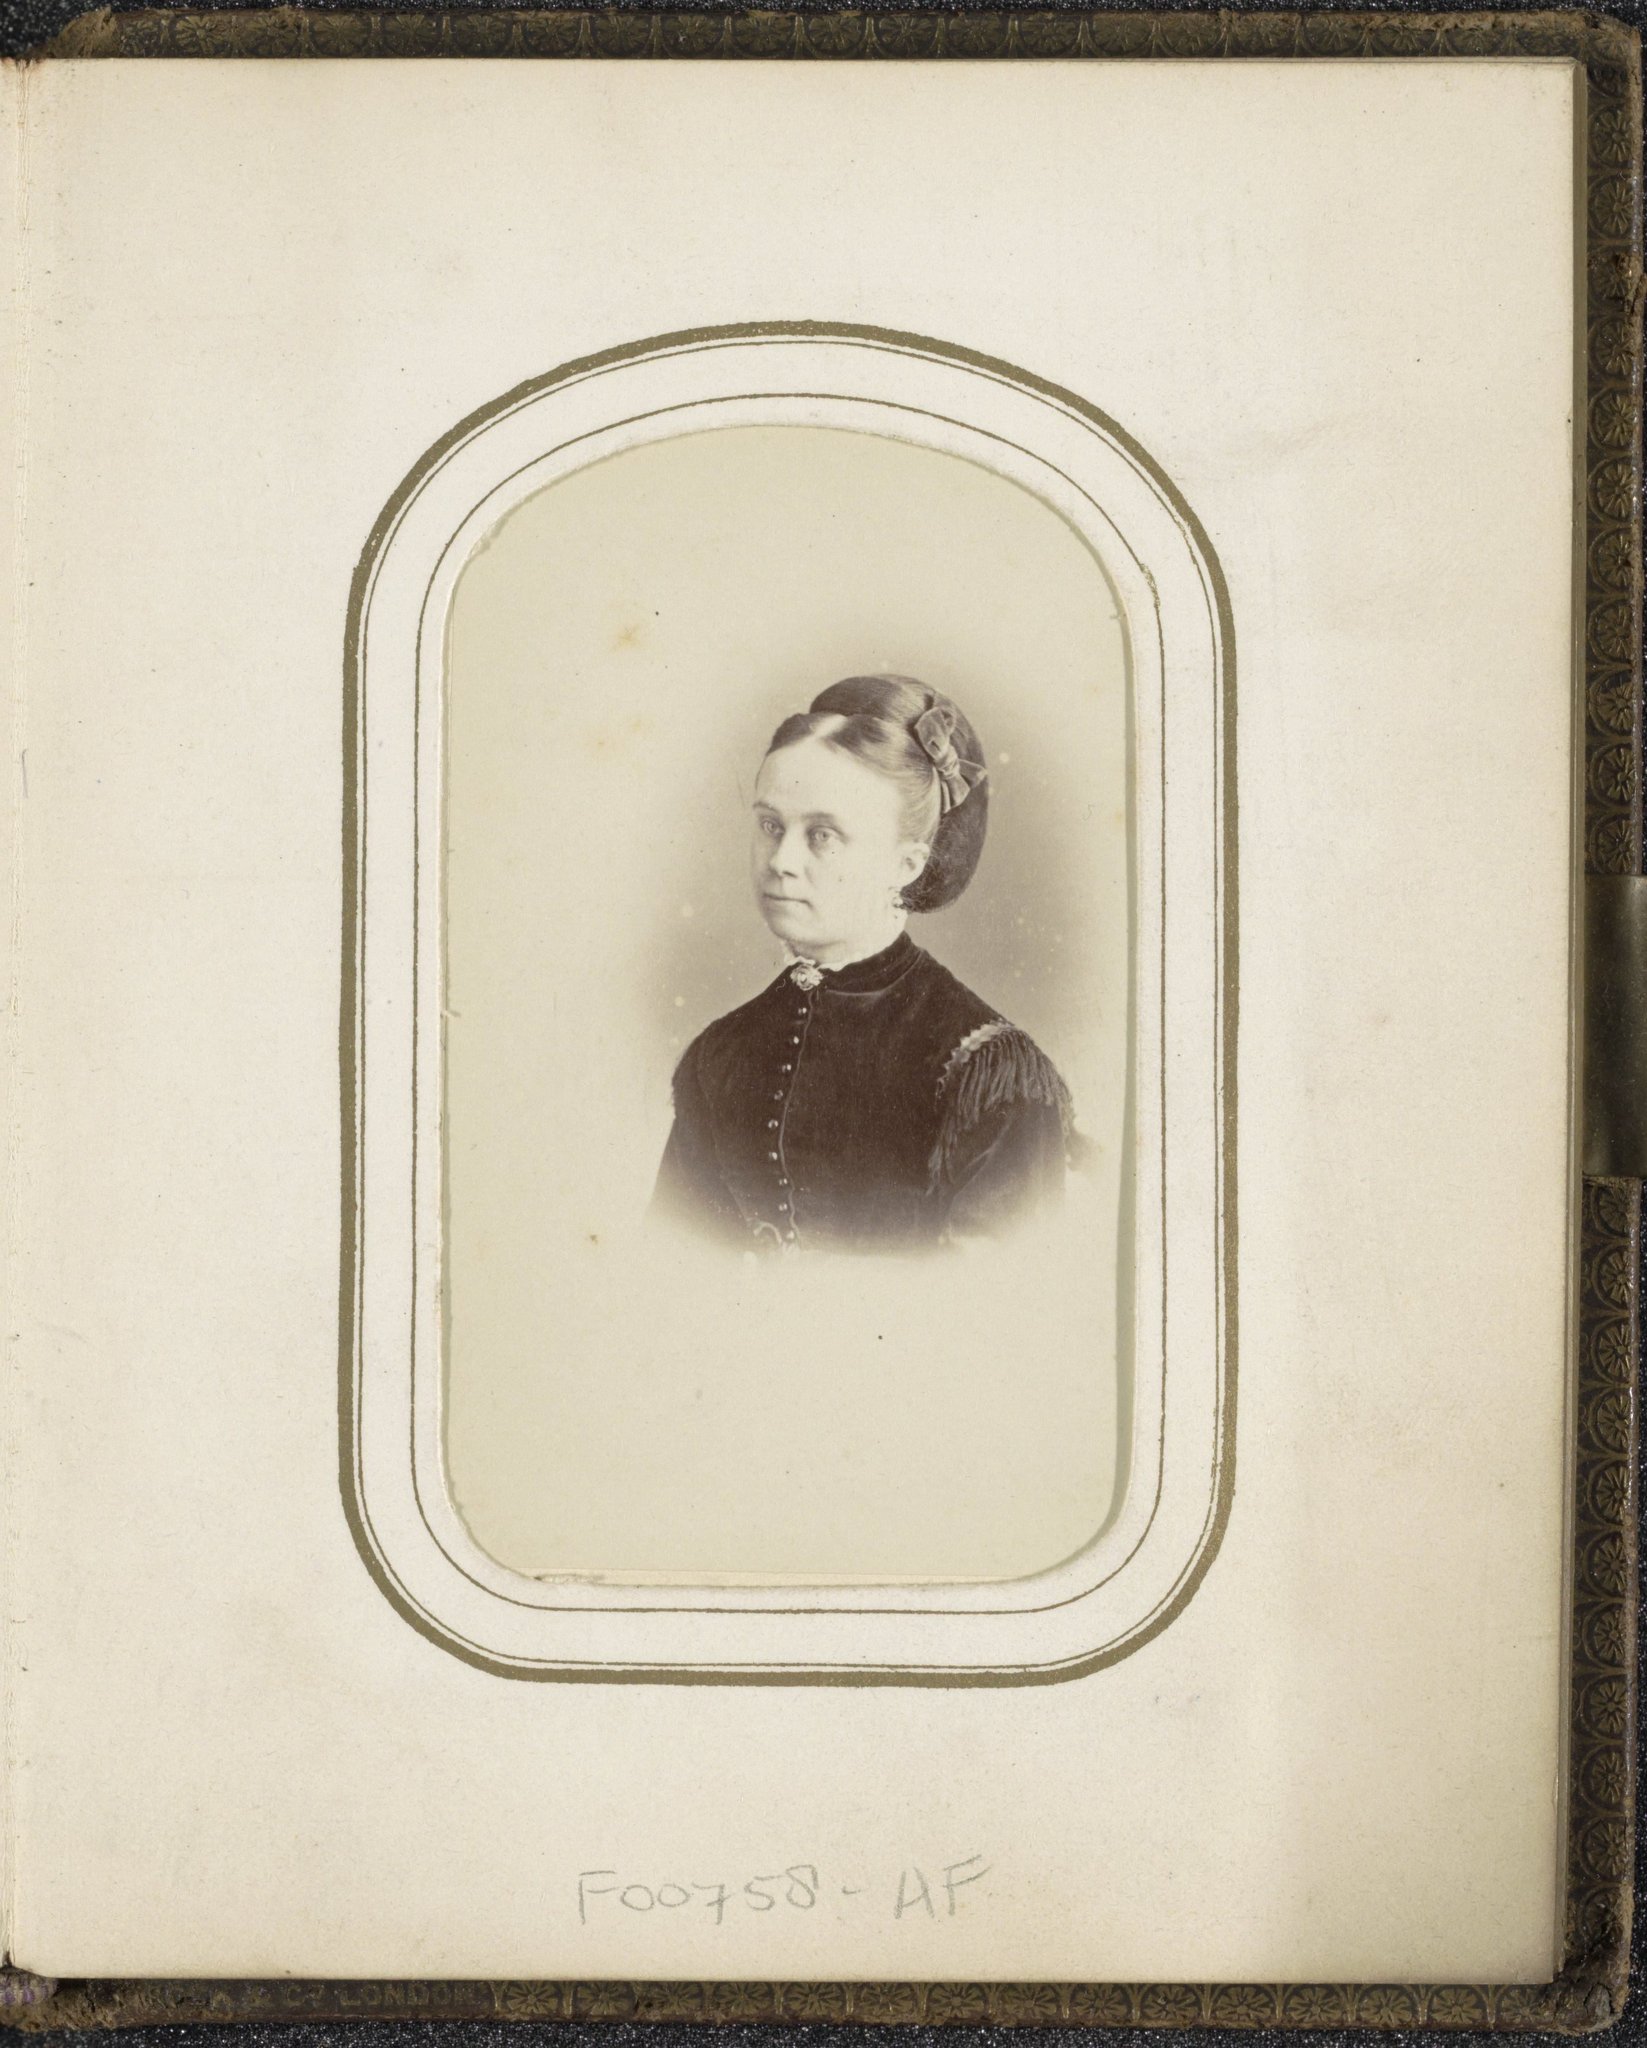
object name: photograph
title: Portret van een vrouw met een hoed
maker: george avery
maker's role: fotograaf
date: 1870-1880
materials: cardboard, paper, photographic support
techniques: albumen print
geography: tonbridge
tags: historical persons, clothing for the upper part of the body, brooch, agraffe, clasp, head-gear: hat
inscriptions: address: ‘Tonbridge (landscape)’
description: Onderdeel van Engels fotoalbum van E.A. Kettle met 42 cartes-de-visite.